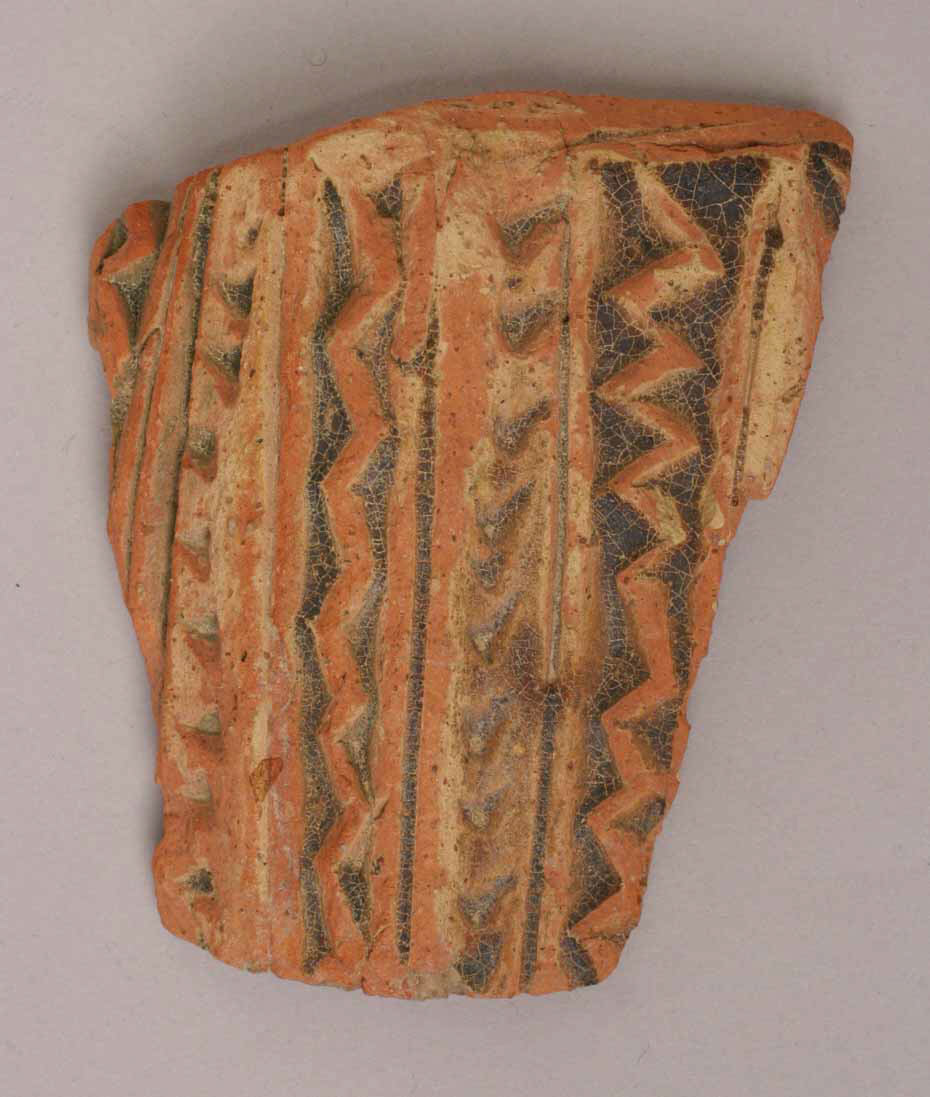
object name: fragment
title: Ceramic Fragment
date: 1001-1100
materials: earthenware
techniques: glazing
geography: saudi arabia